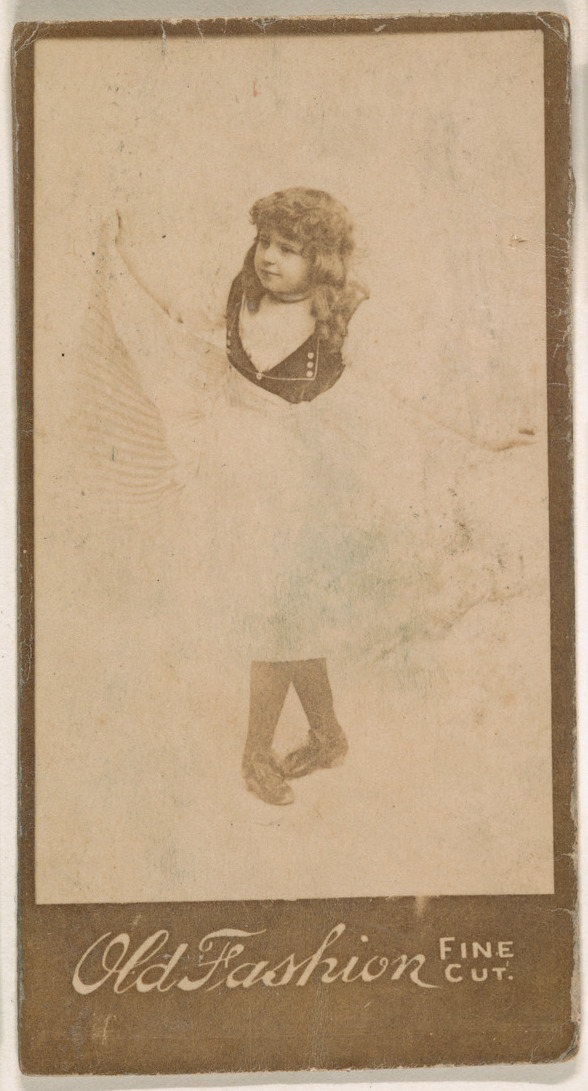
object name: photograph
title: Dancer, from the Actresses series (N664) promoting Old Fashion Fine Cut Tobacco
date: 1888-1890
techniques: albumen silver print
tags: girls,portraits,actresses,dancers